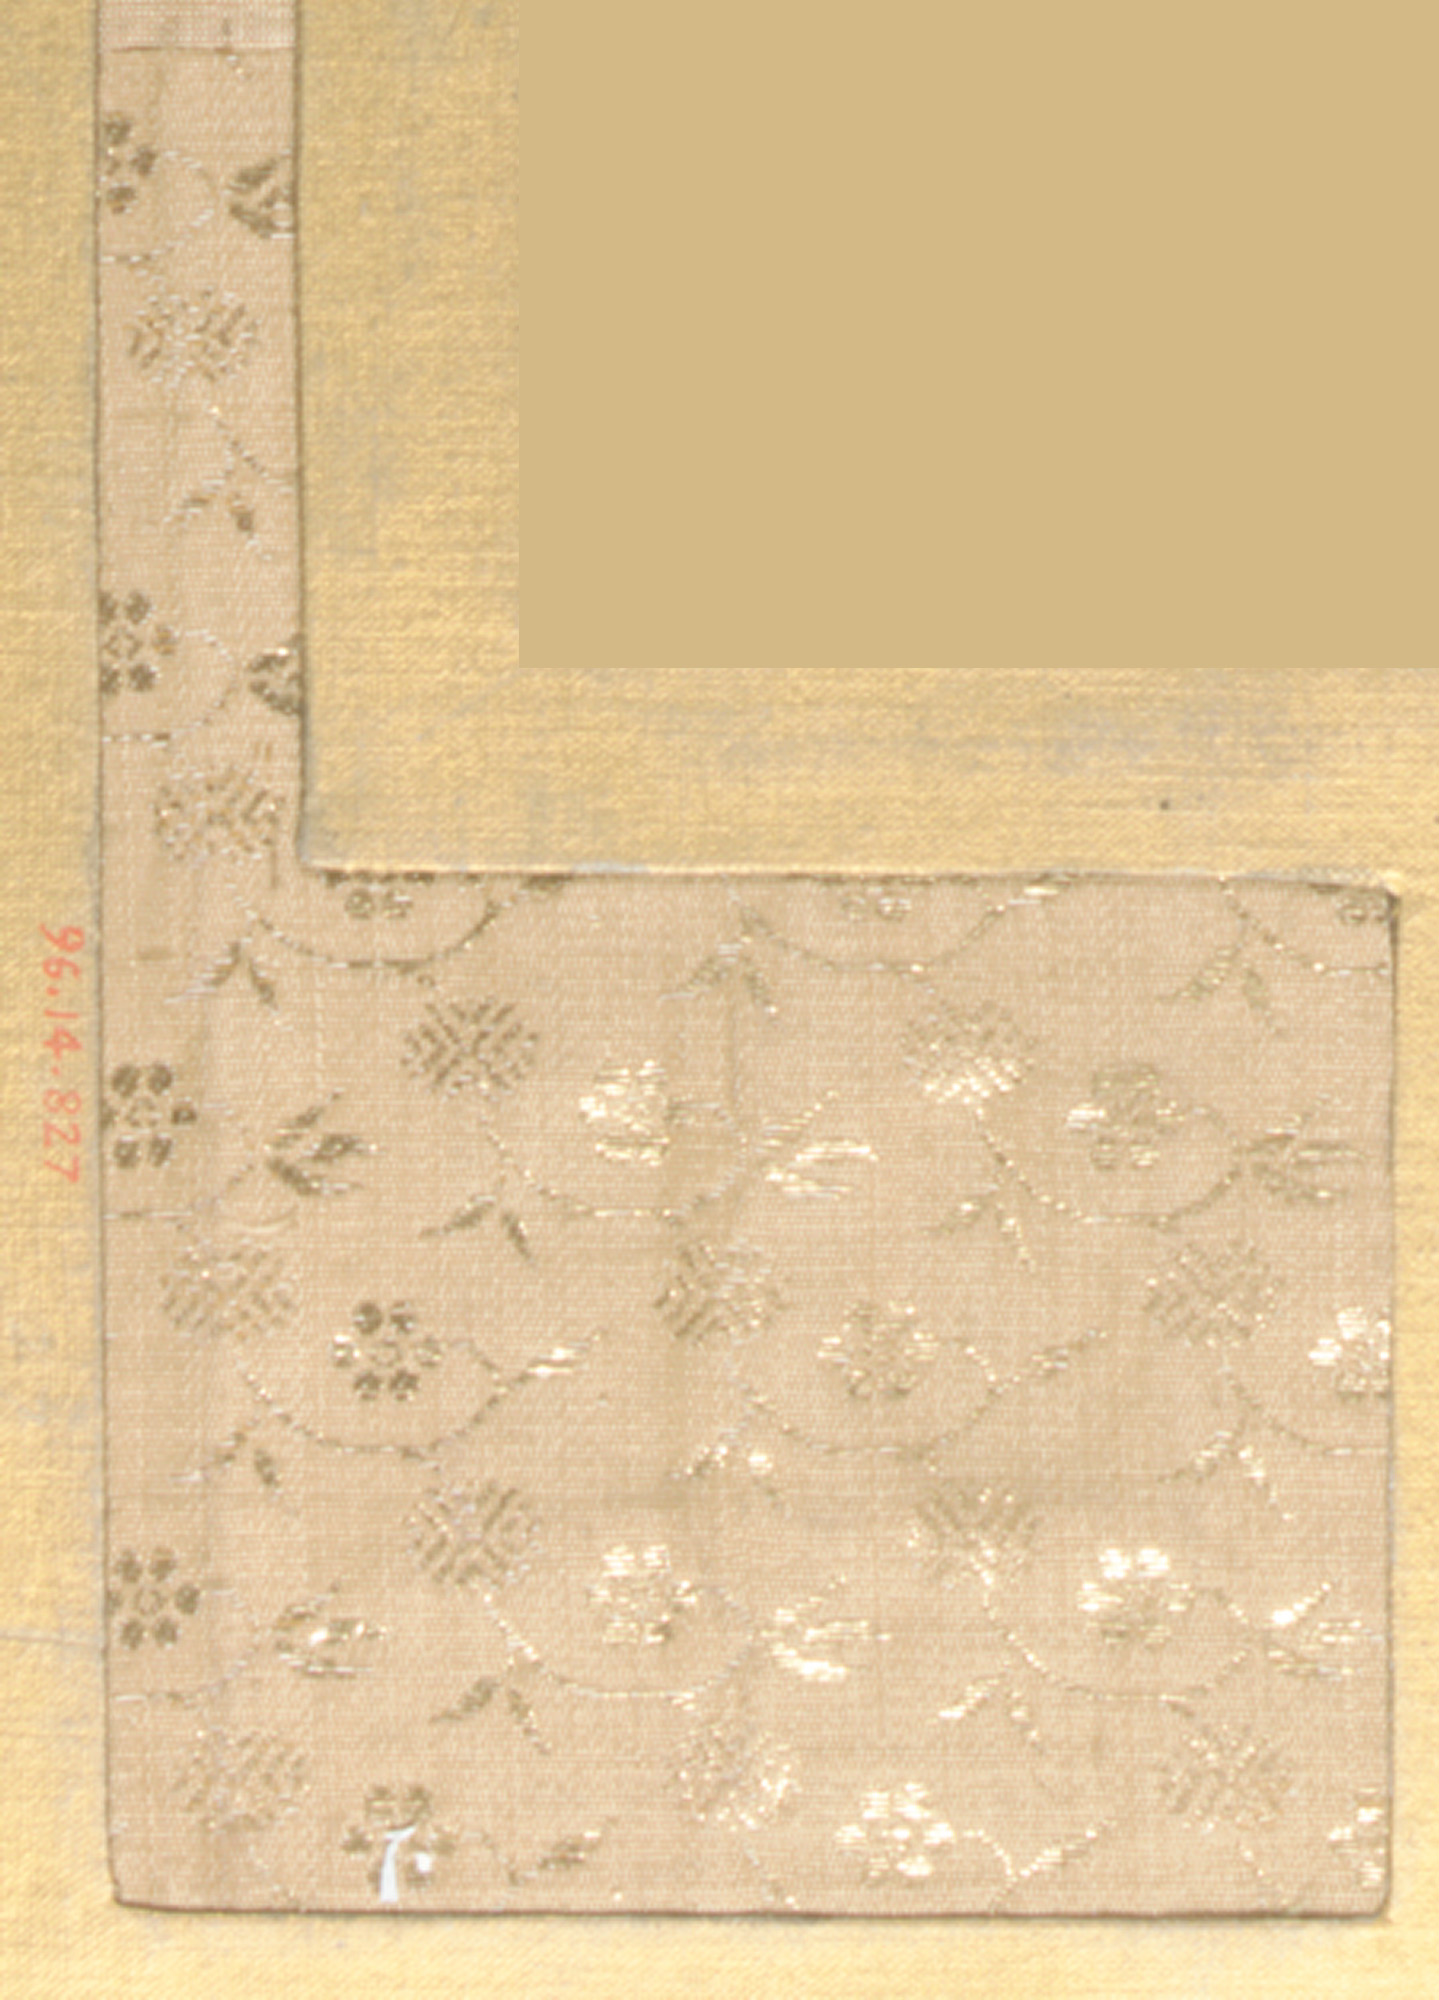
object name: piece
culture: japanese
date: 1701-1900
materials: silk